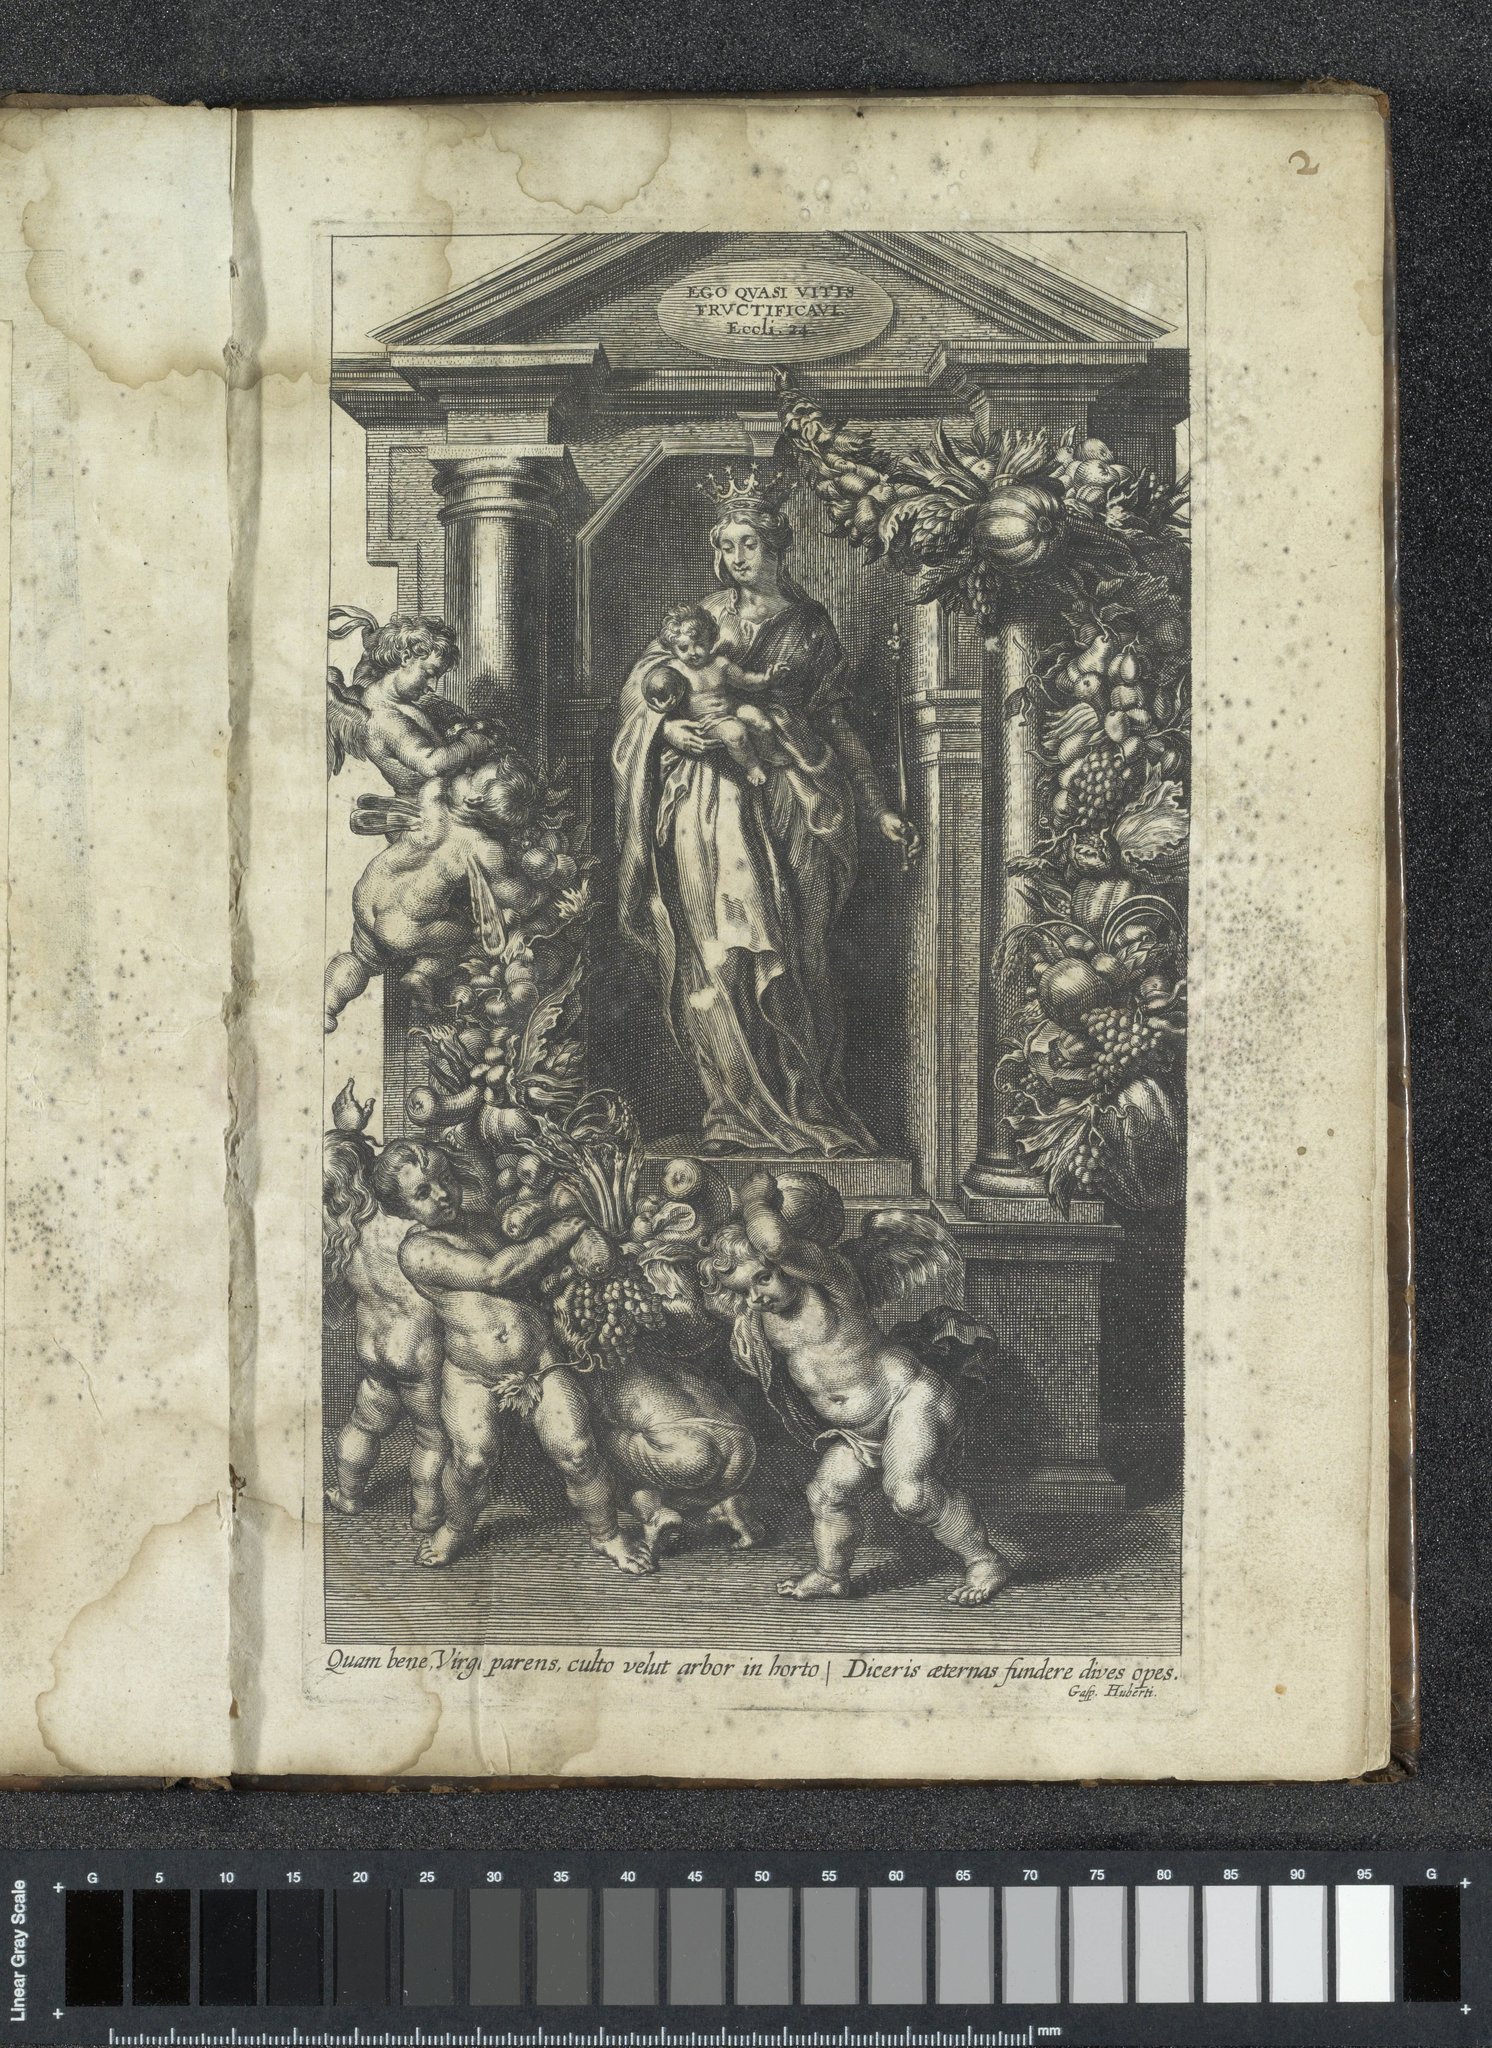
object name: print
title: Maria als koningin met Christuskind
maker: gaspar huybrechts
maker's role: print maker, publisher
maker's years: 1619-1684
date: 1661-1684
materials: paper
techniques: engraving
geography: antwerp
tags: madonna: mary standing (or half-length), christ-child close to her bosom, garland, wreath, 'regina coeli', 'regina angelorum', 'maestà' ~ madonna, (children or putti) blowing bubbles, 'homo bulla' ~ scene symbolizing 'vanitas'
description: Maria, staande in een nis, met kroon op het hoofd en scepter in de hand, het Christuskind op haar arm. Putti dragen een guirlande van vruchten. Onder de voorstelling een tekst in het Latijn. Prent maakt deel uit van een album.